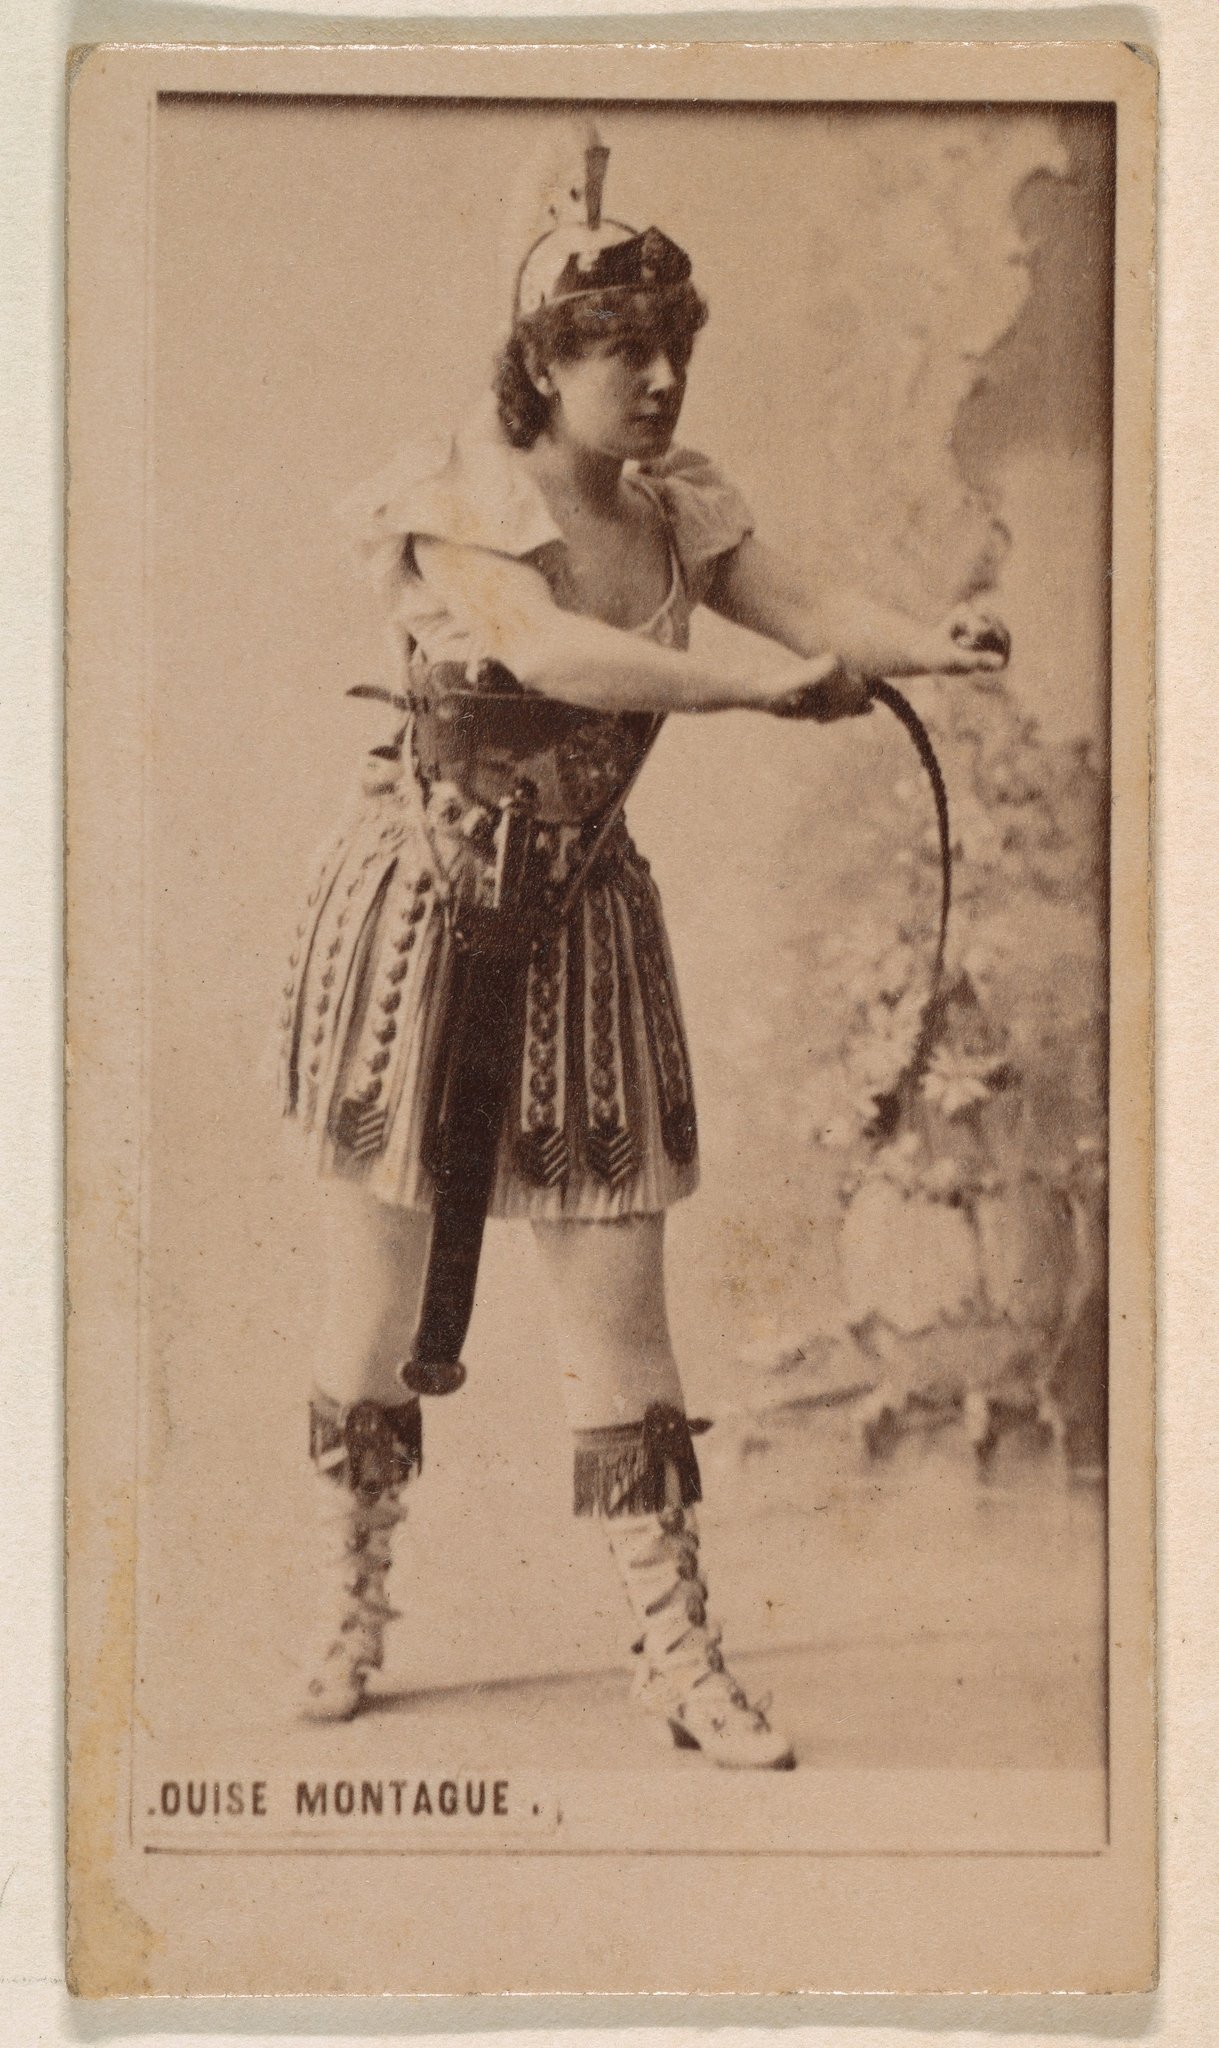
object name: photograph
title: Louise Montague, from the Actresses series (N245) issued by Kinney Brothers to promote Sweet Caporal Cigarettes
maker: kinney brothers tobacco company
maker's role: publisher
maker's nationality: american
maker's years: 1869-2011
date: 1890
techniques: albumen silver print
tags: portraits,women,actresses